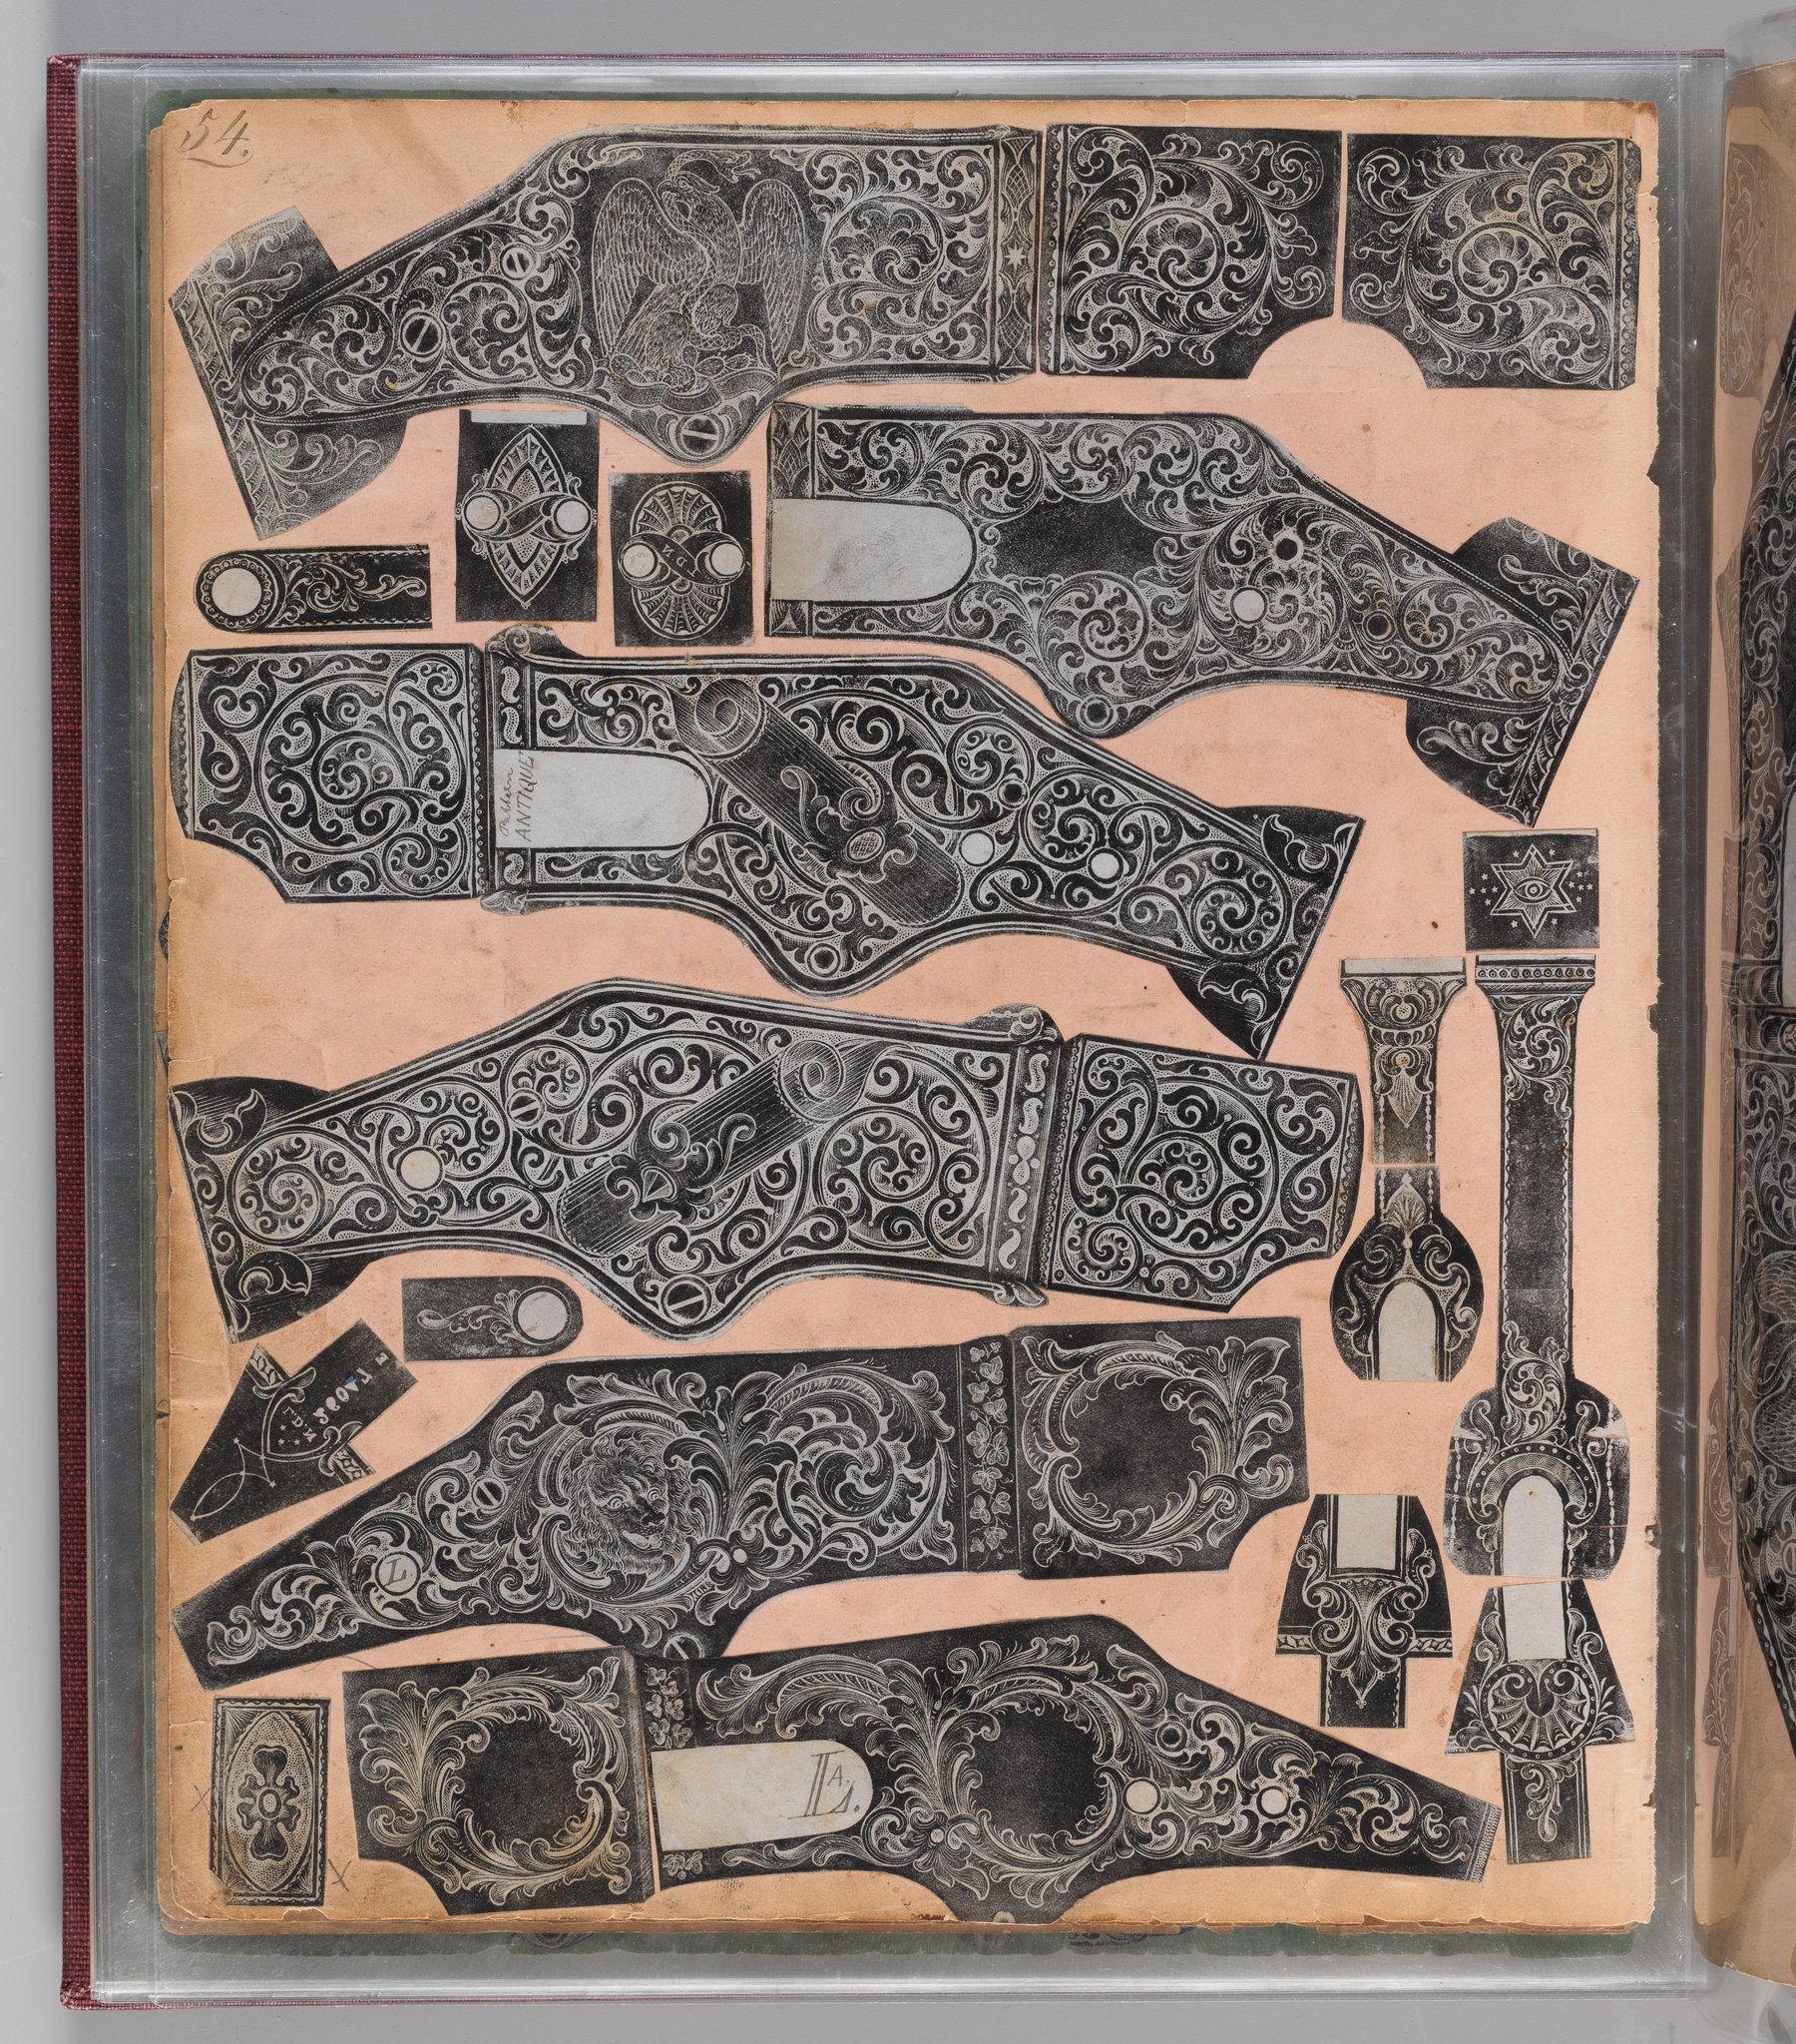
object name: scrapbook of engraving design for firearm ornament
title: Workbook Recording the Engraved Firearms Ornament of Louis D. Nimschke (1832–1904)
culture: american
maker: louis daniel nimschke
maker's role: artist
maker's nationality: american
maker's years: 1825-1925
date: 1850-1900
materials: ink, leather, paper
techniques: bookbinding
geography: united states